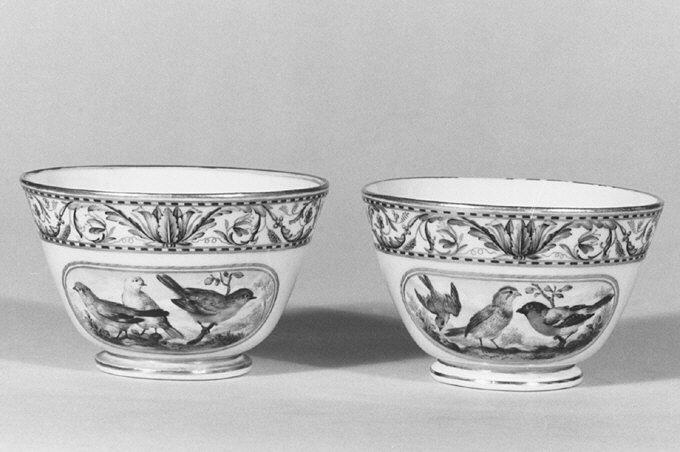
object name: teacup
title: Teacup (part of a service)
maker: meissen manufactory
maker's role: manufactory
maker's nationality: german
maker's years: 1710-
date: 1780-1785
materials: hard paste porcelain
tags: birds